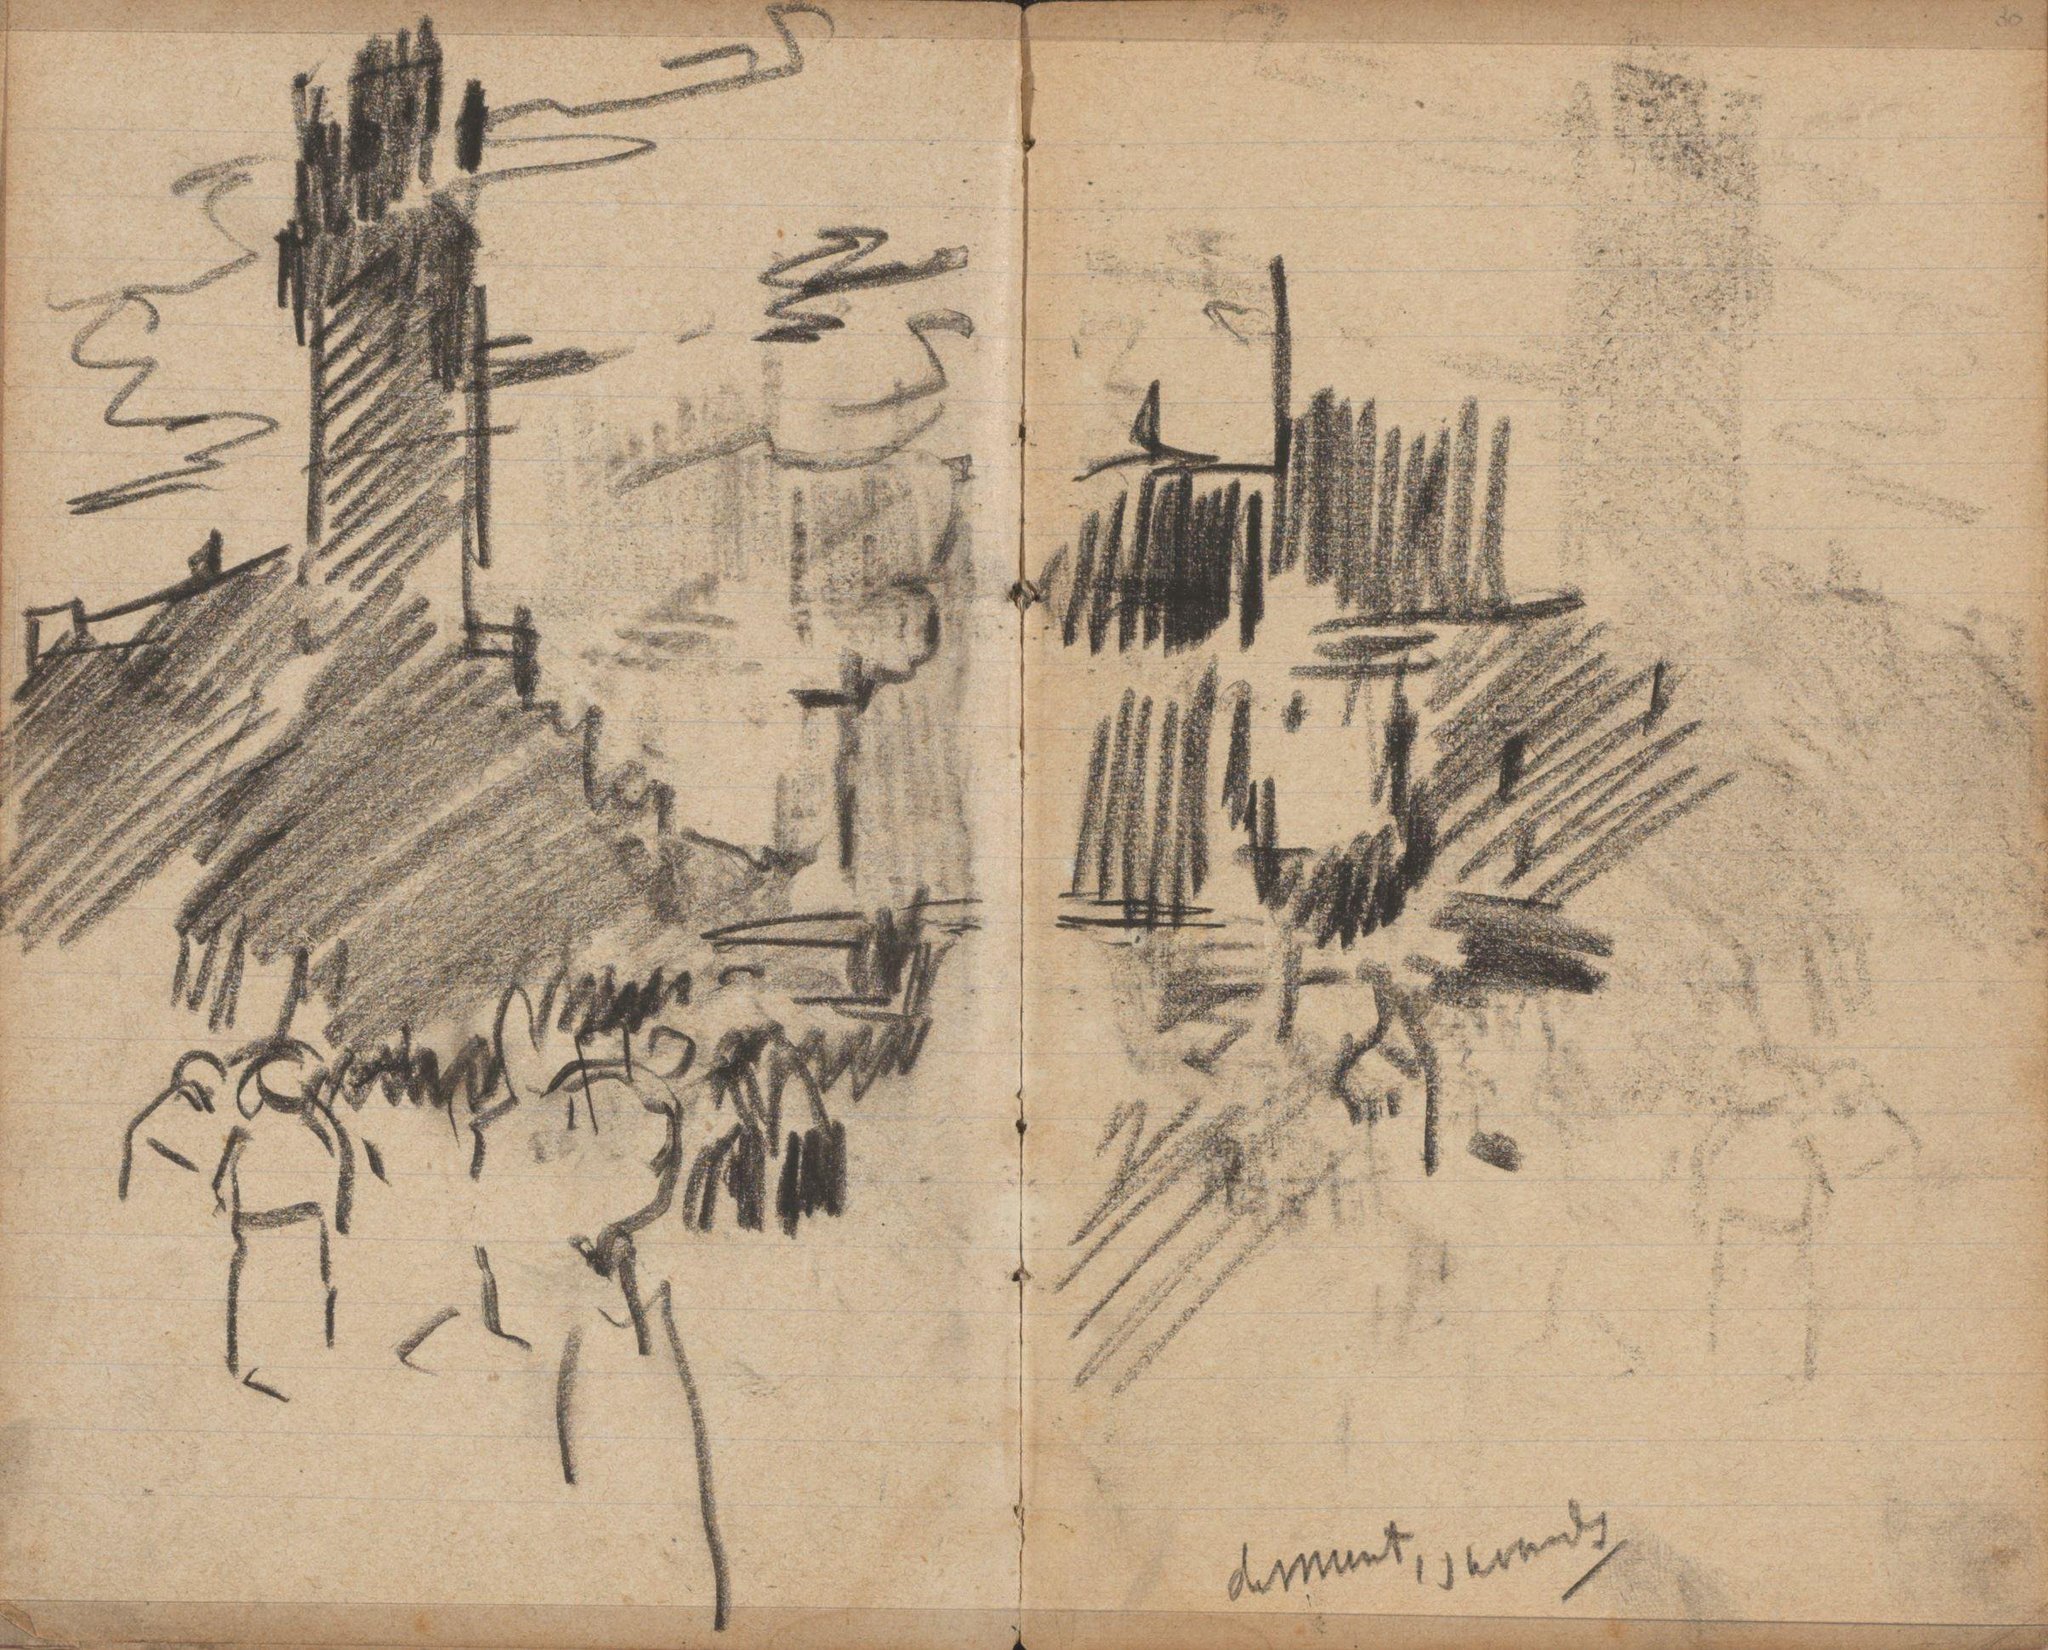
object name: sketchbook leaf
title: Gezicht op het Muntplein te Amsterdam met de Munttoren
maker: george hendrik breitner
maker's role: draughtsman, painter, print maker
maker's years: 1857-1923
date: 1886-1903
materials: chalk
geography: amsterdam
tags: civic architecture; edifices; dwellings, square, place, circus, etc. (+ city(-scape) with figures, staffage)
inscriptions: annotation: ‘de Munt/ 's avonds’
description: Pagina 29 en pagina 30 uit een schetsboek met 41 bladen.